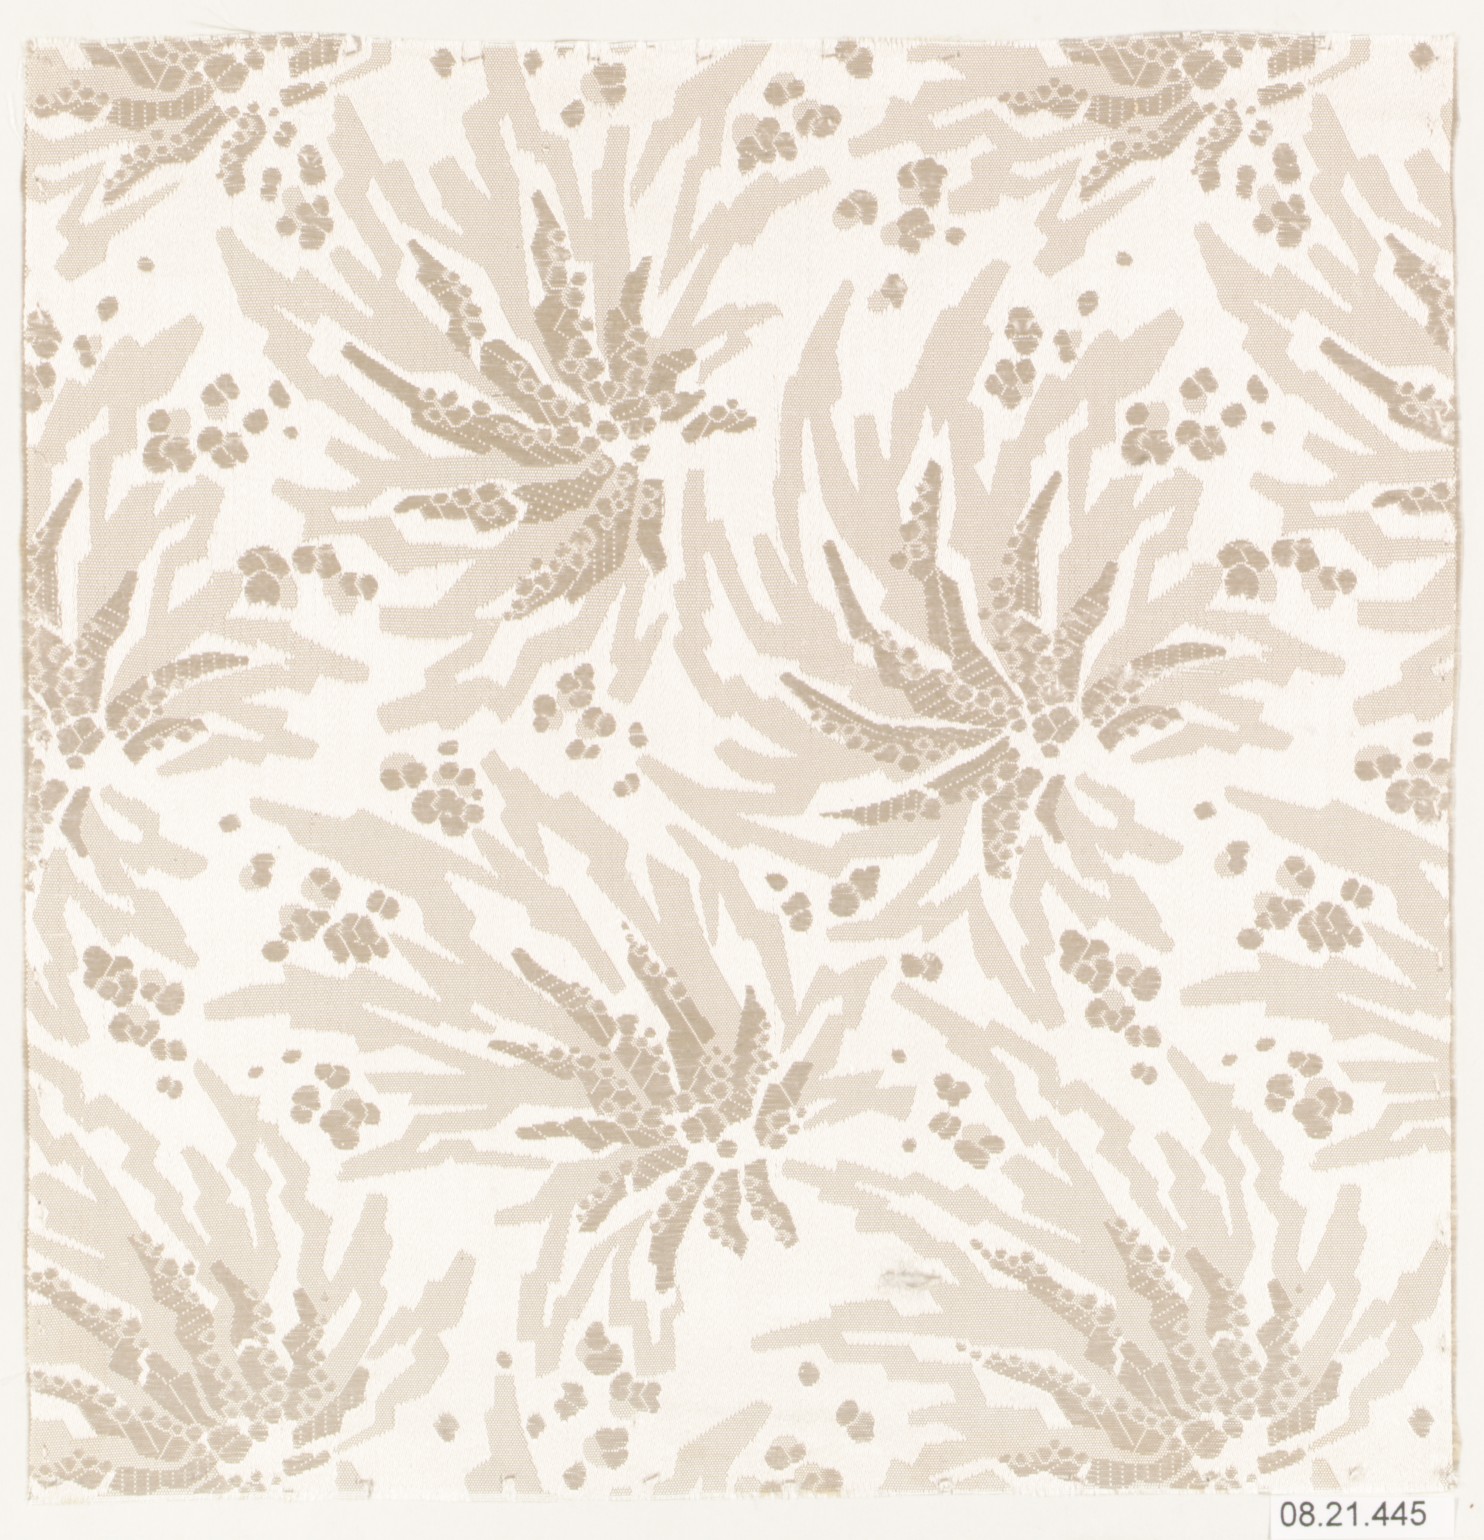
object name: textile sample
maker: Anonymous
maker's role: designer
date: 1900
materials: silk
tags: leaves